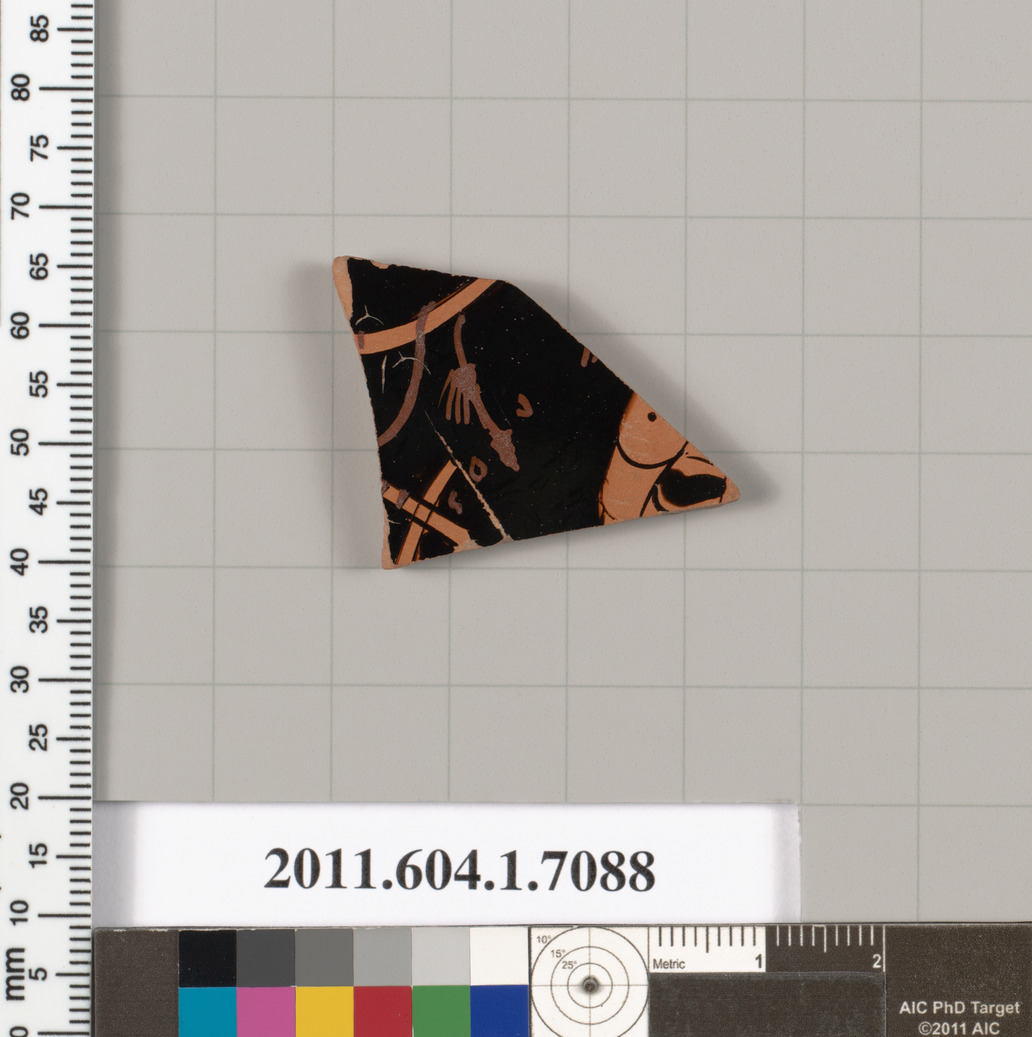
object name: kylix fragment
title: Terracotta fragment of a kylix (drinking cup)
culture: greek, attic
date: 500-480 BCE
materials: terracotta